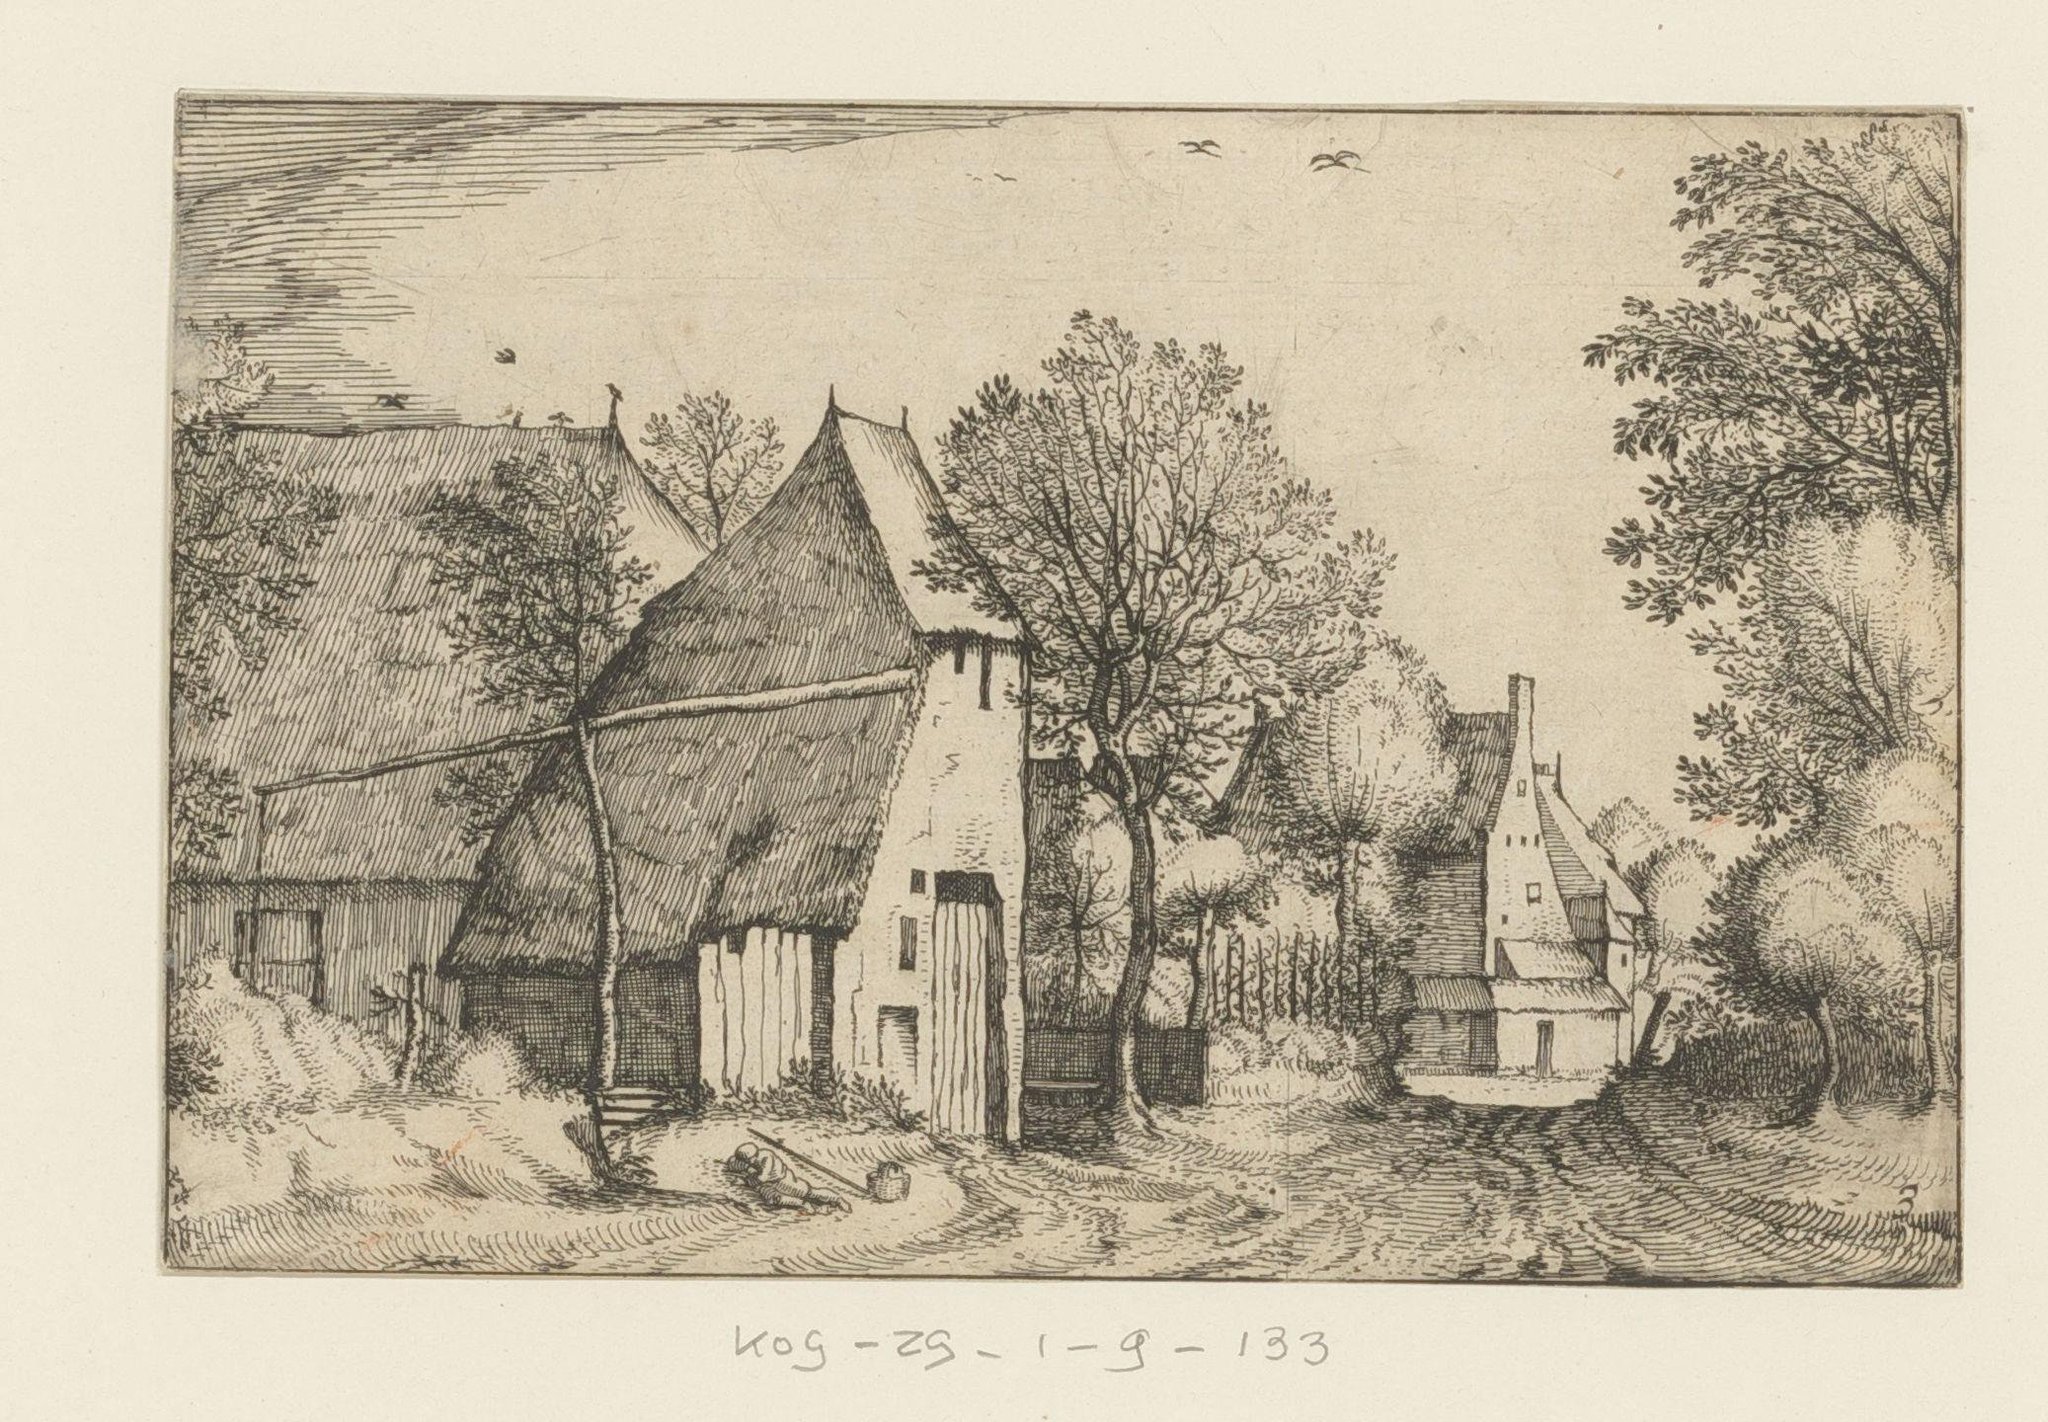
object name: print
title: Verschillende regio's en steden in het hertogdom Brabant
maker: claes jansz. visscher (ii)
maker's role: draughtsman, print maker, publisher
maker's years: 1586-1652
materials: paper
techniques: etching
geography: amsterdam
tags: village street, sleeping on the ground, farm or solitary house in landscape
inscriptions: stamp, collector's mark: Lugt 1641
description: Gezicht op een landweg met links enkele huizen en een man die bij een put ligt te rusten. In de lucht vliegen vogels. Prent uit een serie bestaande uit één titelprent en 25 prenten. Rechtsonder genummerd: 3. Onderwerpsrubrieken binnen de Atlas Zeden en Gewoonten: Handel, nijverheid en verkeer, Buitenleven.